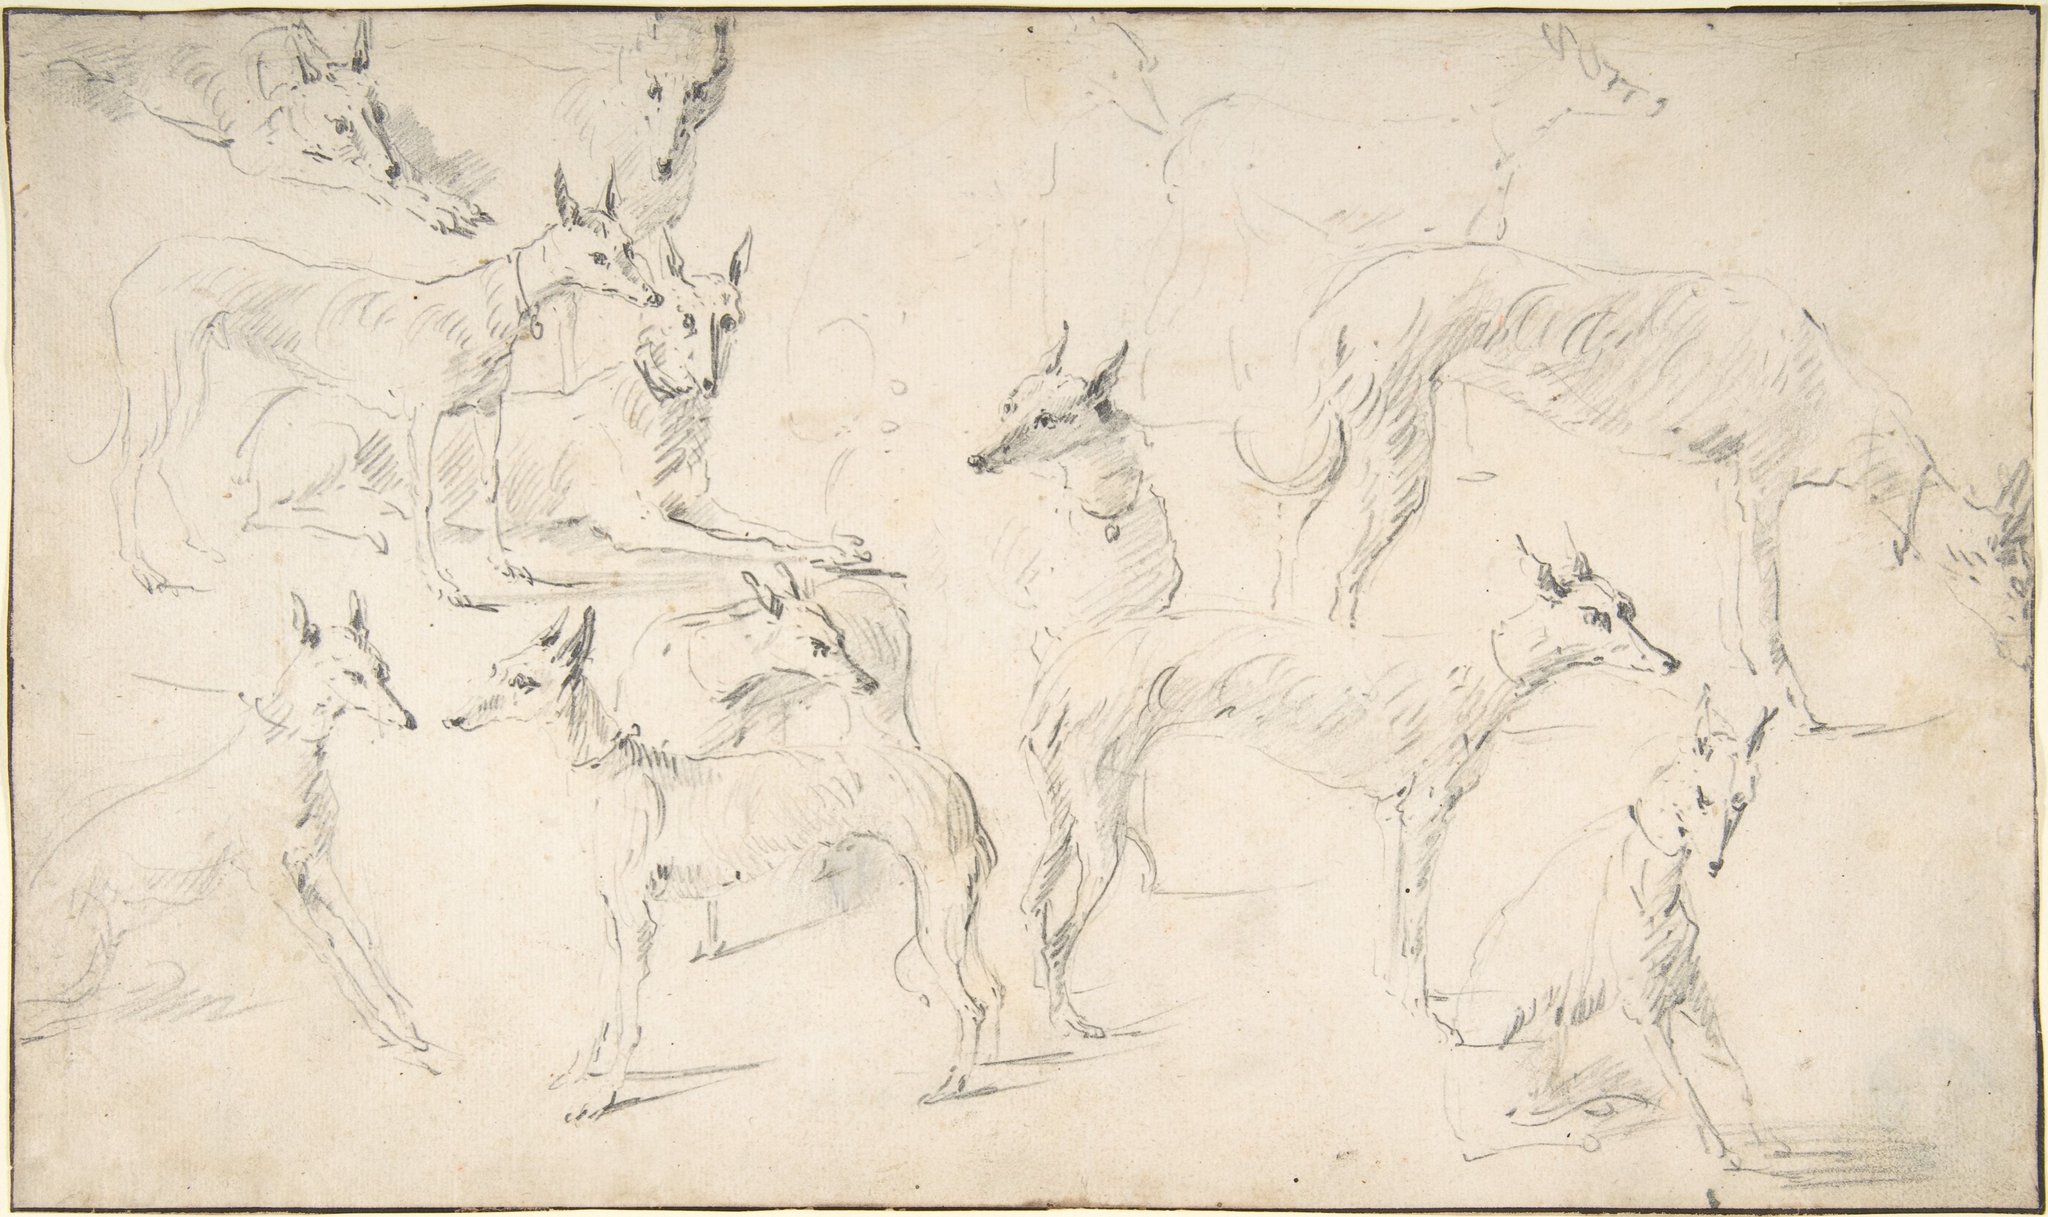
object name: drawing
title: Studies of Hounds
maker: david teniers the younger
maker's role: artist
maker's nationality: flemish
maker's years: 1610-1690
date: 1601-1700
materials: graphite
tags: dogs